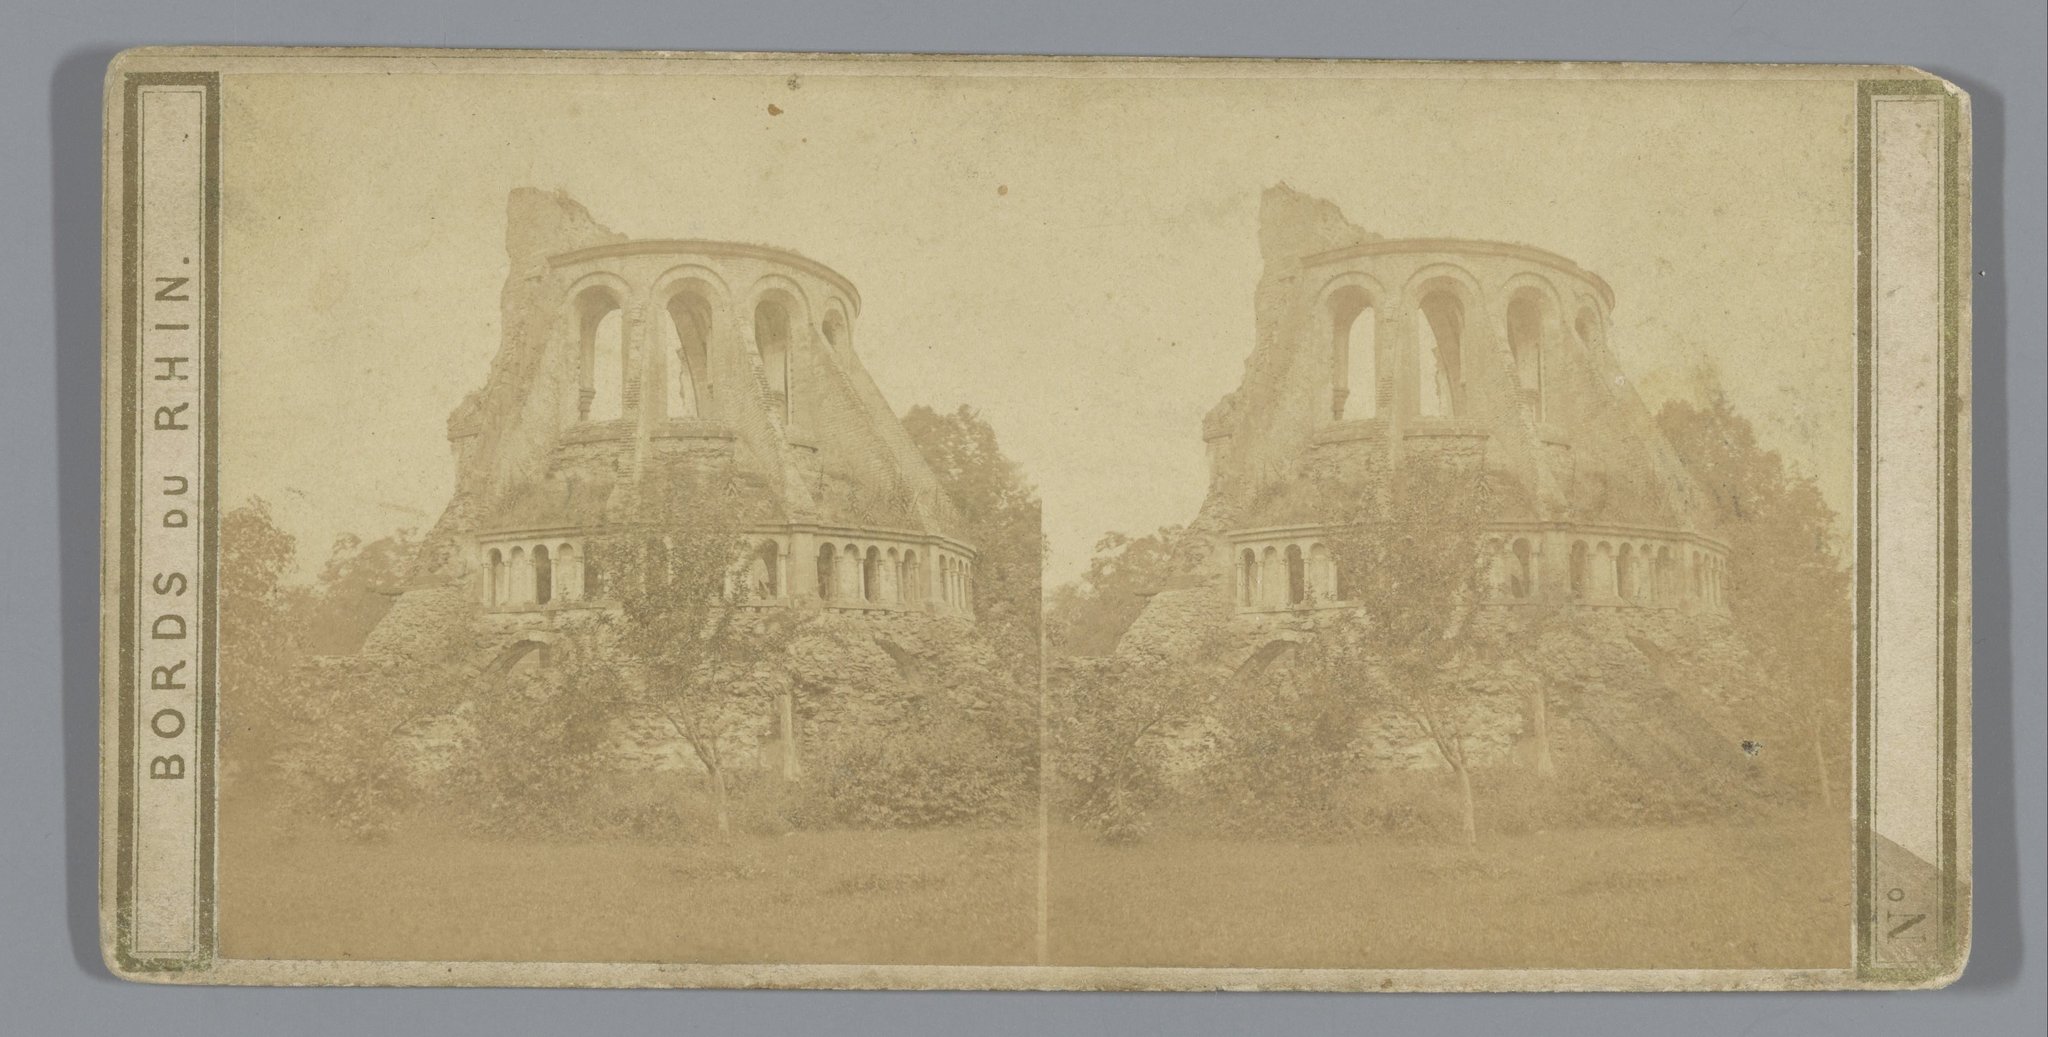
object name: stereograph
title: Ruïne van de Abdij van Heisterbach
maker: alexandre bertrand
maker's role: fotograaf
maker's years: 1822-1889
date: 1865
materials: cardboard, photographic support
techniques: albumen print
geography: north rhine-westphalia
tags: ruin of church, monastery, etc.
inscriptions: number: ‘53’